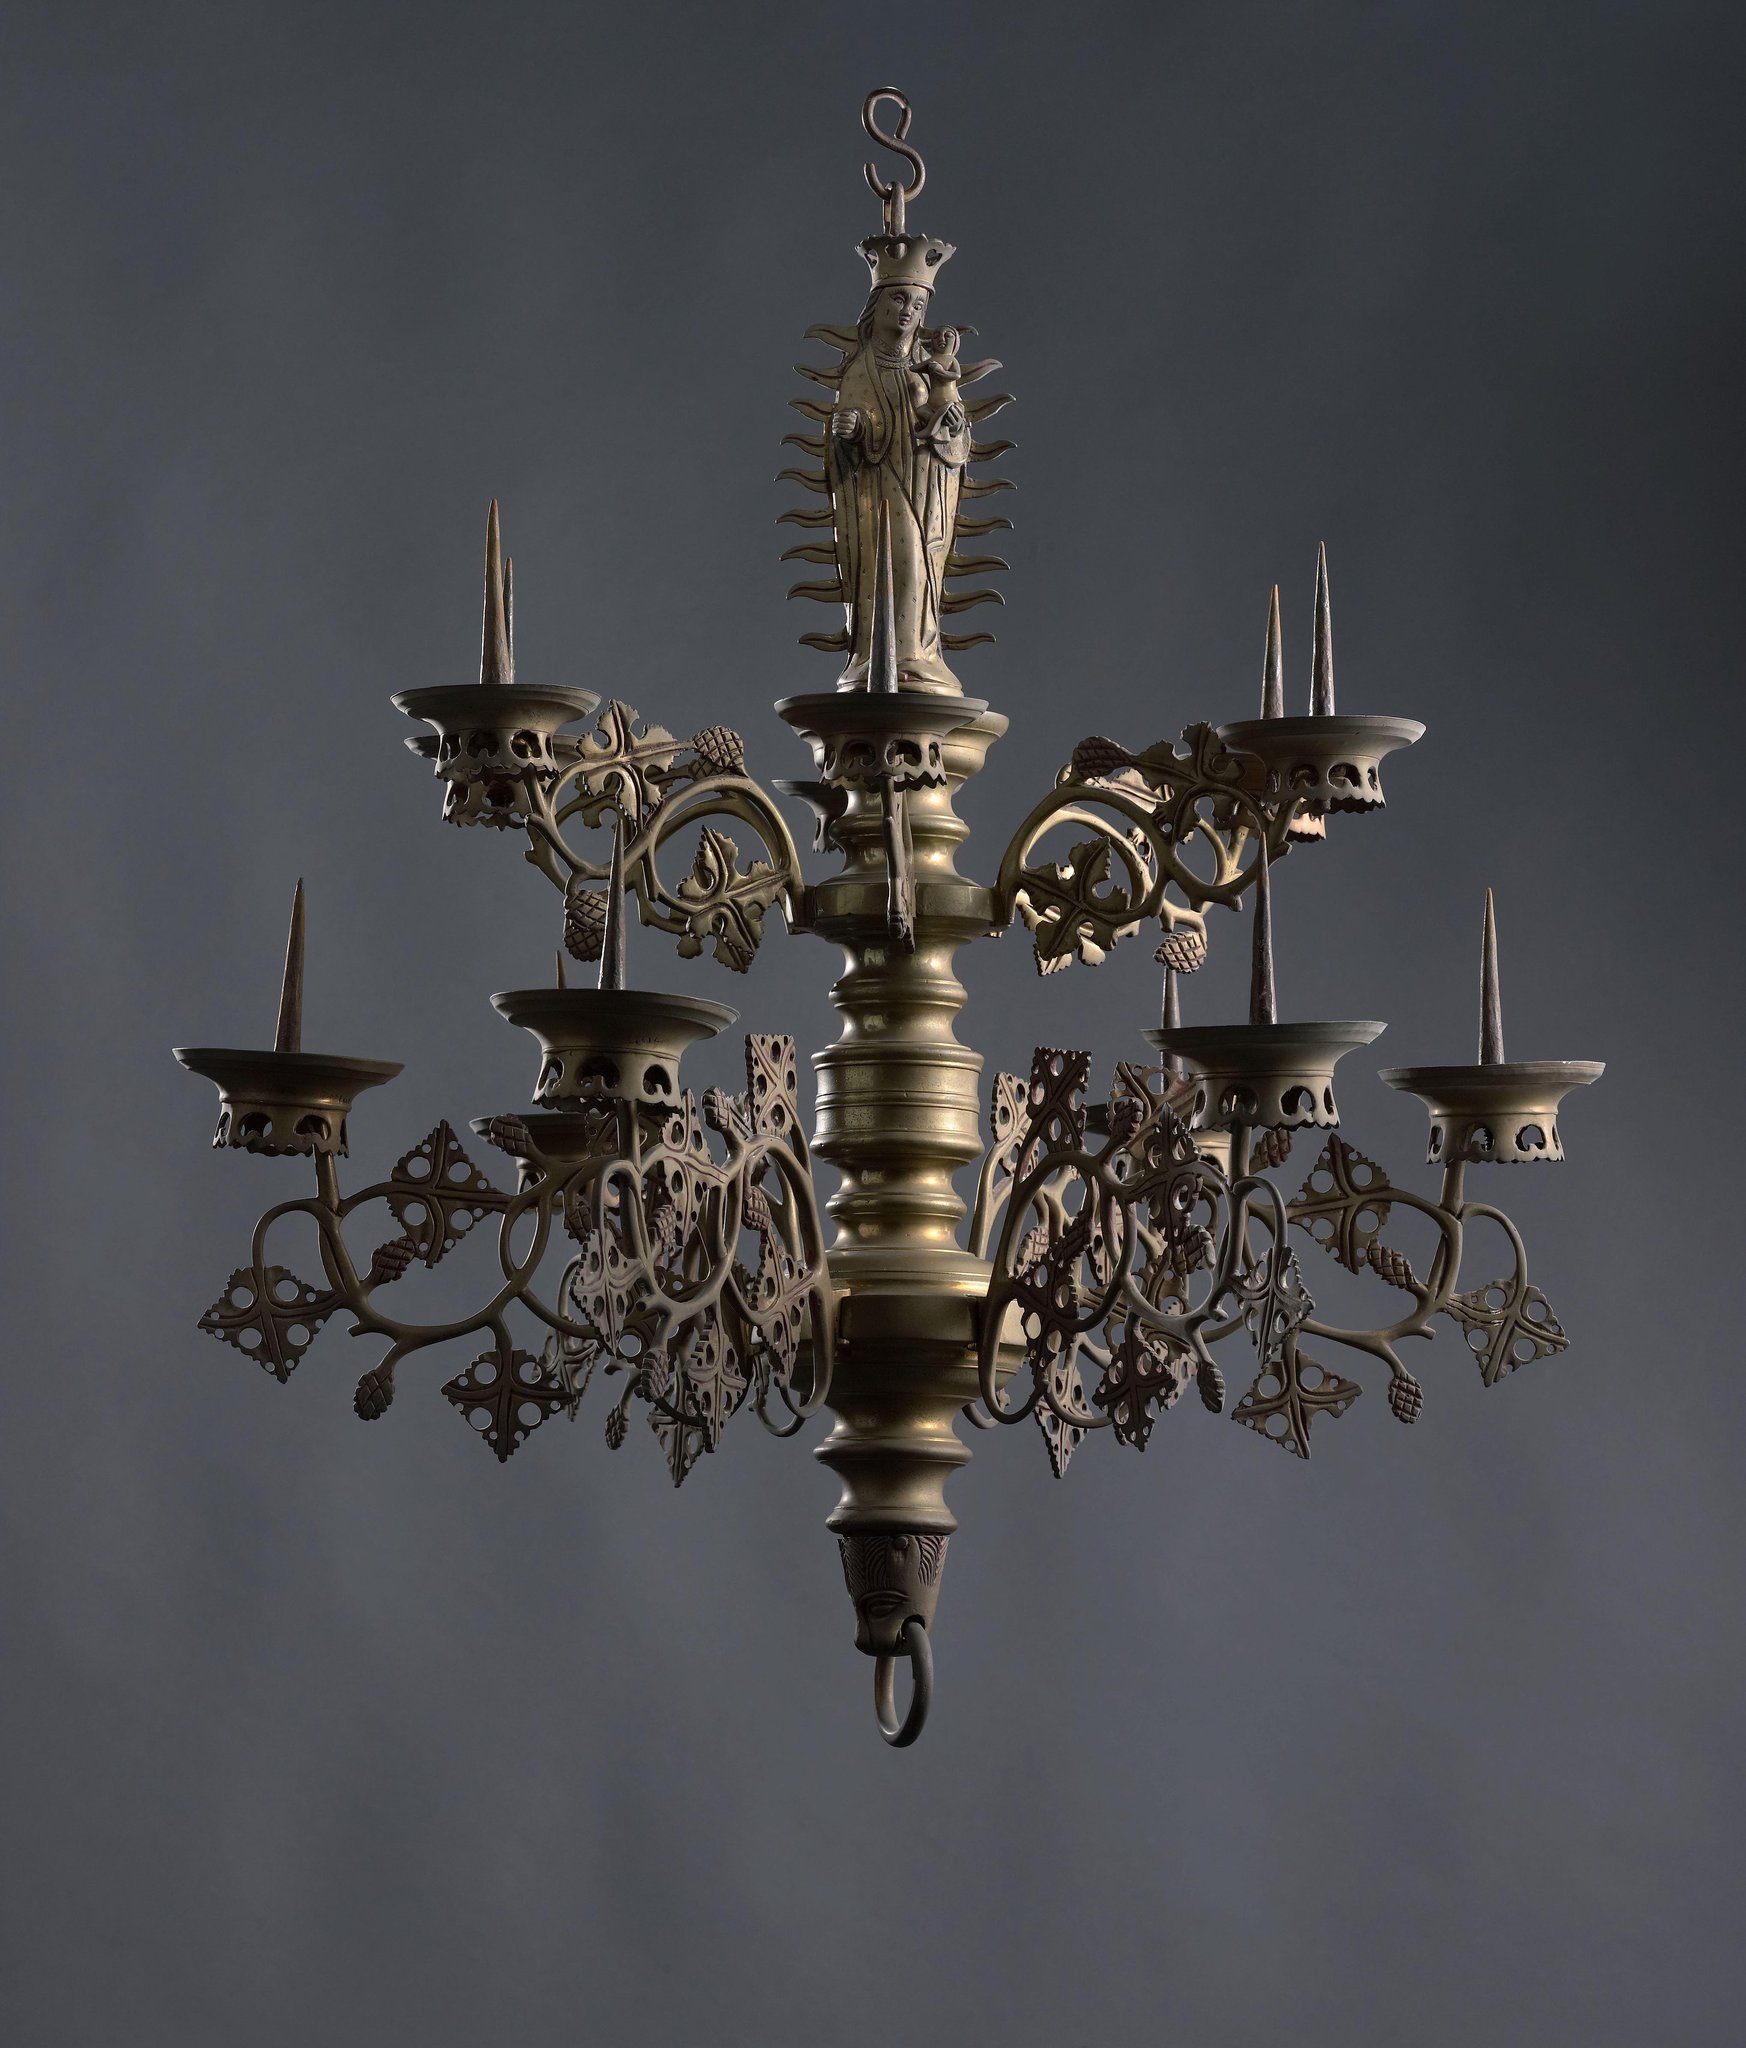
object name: chandelier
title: Arm met kaarsenhouder van kaarsenkroon van twee hoogten met ieder zes armen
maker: Anonymous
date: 1475-1500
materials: brass, iron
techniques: casting, metalworking, forging, screwed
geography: southern netherlands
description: Kaarsenarm behorende bij een kaarsenkroon van twee hoogten met Mariafiguur bovenaan. De arm is twee maal gebogen en is versierd met twee druiventrossen en twee wingerdbladeren. De ronde vetvanger heeft aan de onderkant opengewerkte, gekartelde verticaal geplaatste randen, ter maskering van de bevestiging op de arm. Dit geschiedt door een ronde ijzeren pin, die in het einde van de arm is geschroefd. Dit is de zesde arm van de bovenste ring, ongenummerd. De vetvanger is ongenummerd.